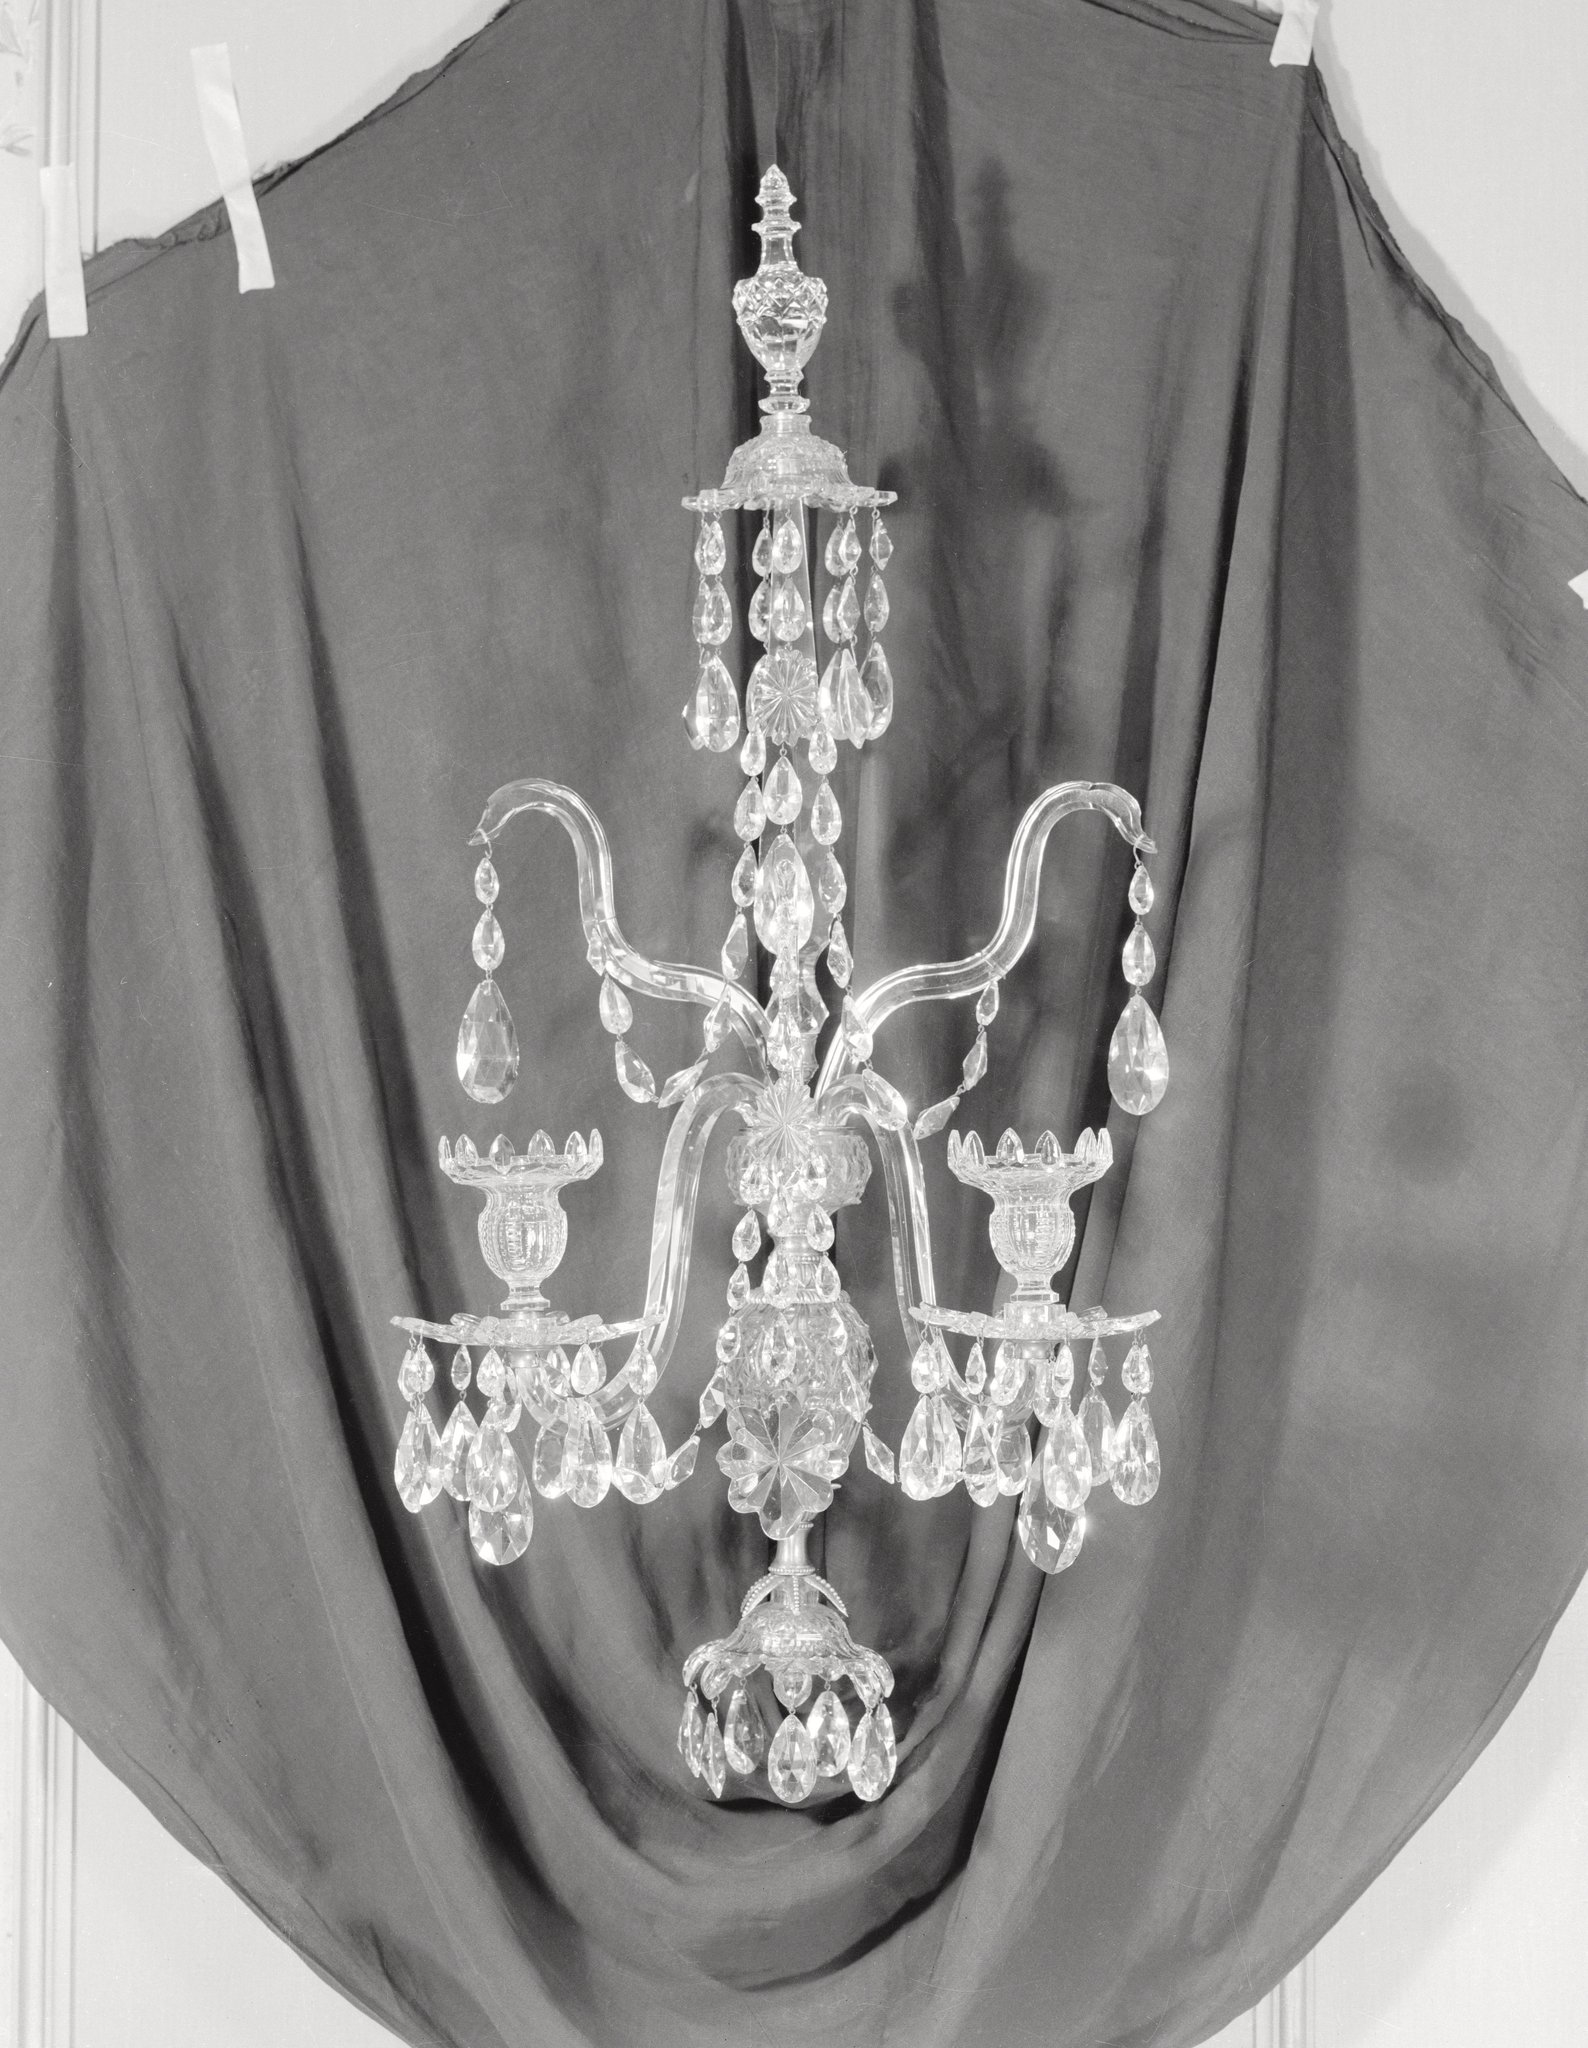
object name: sconce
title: Pair of sconces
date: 1785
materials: gilt bronze, glass